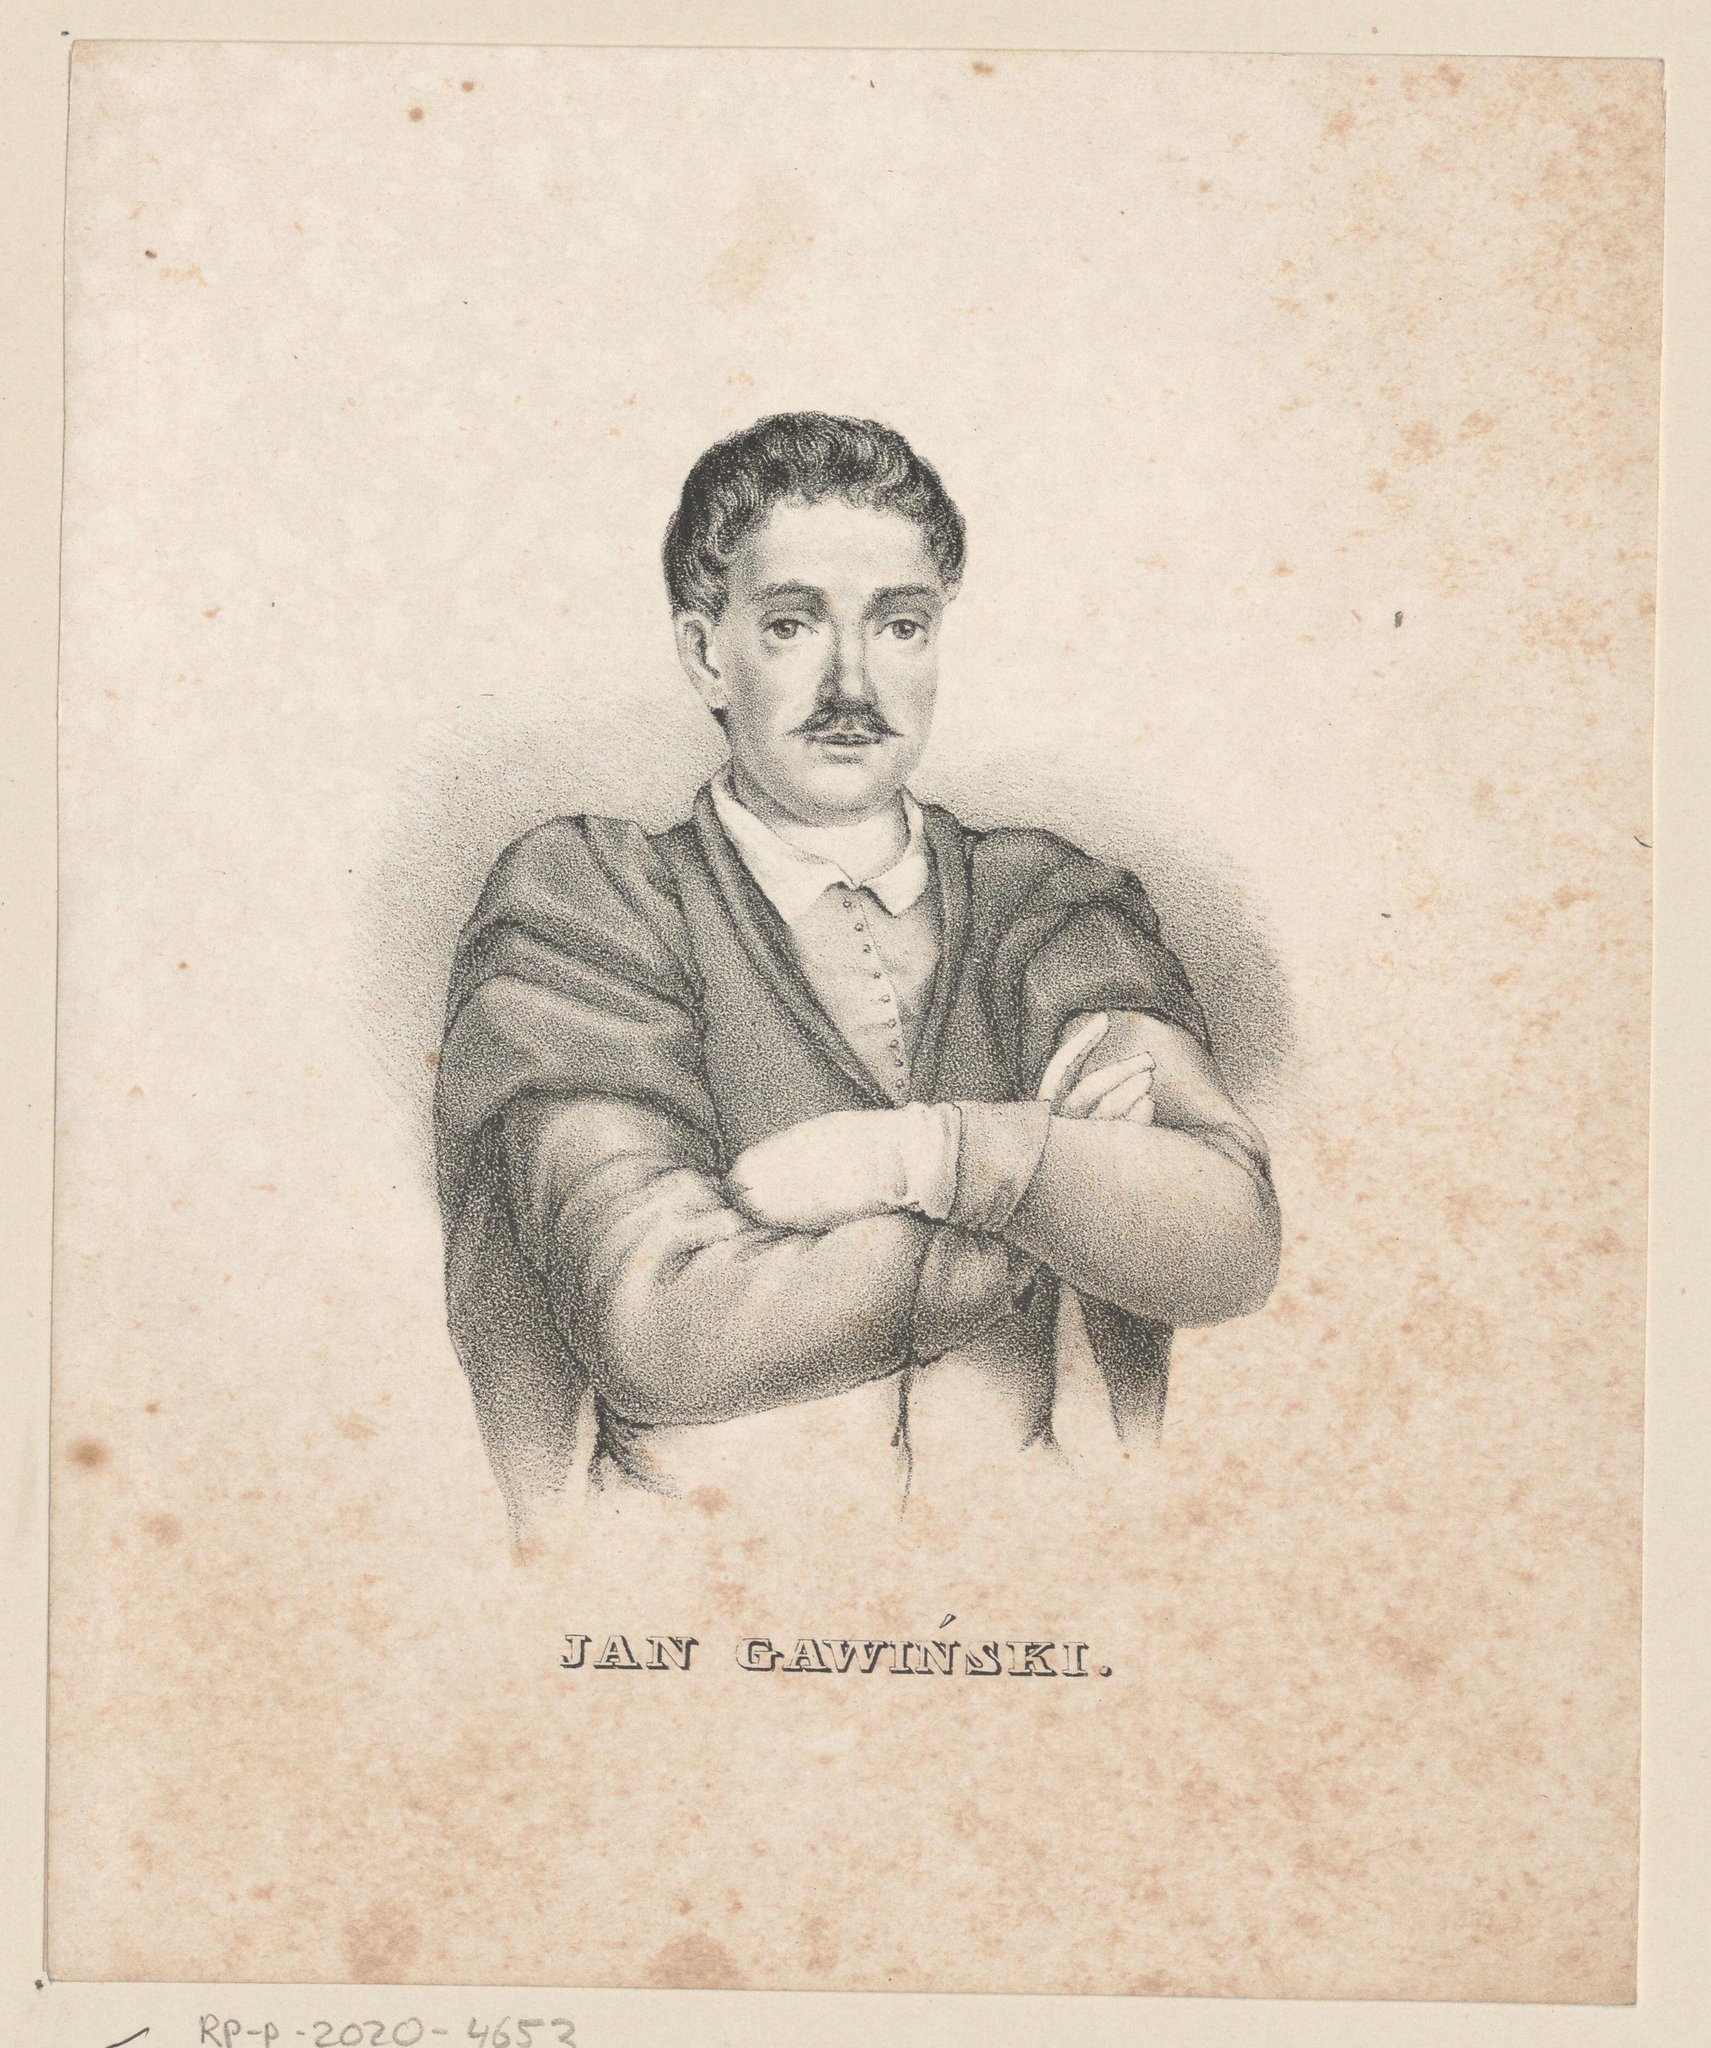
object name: print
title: Portret van Jan Gawiński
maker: Anonymous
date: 1750-1794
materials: paper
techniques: engraving, etching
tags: historical persons, writer, poet, author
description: Tekst in het Latijn in de omlijsting en in de ondermarge.